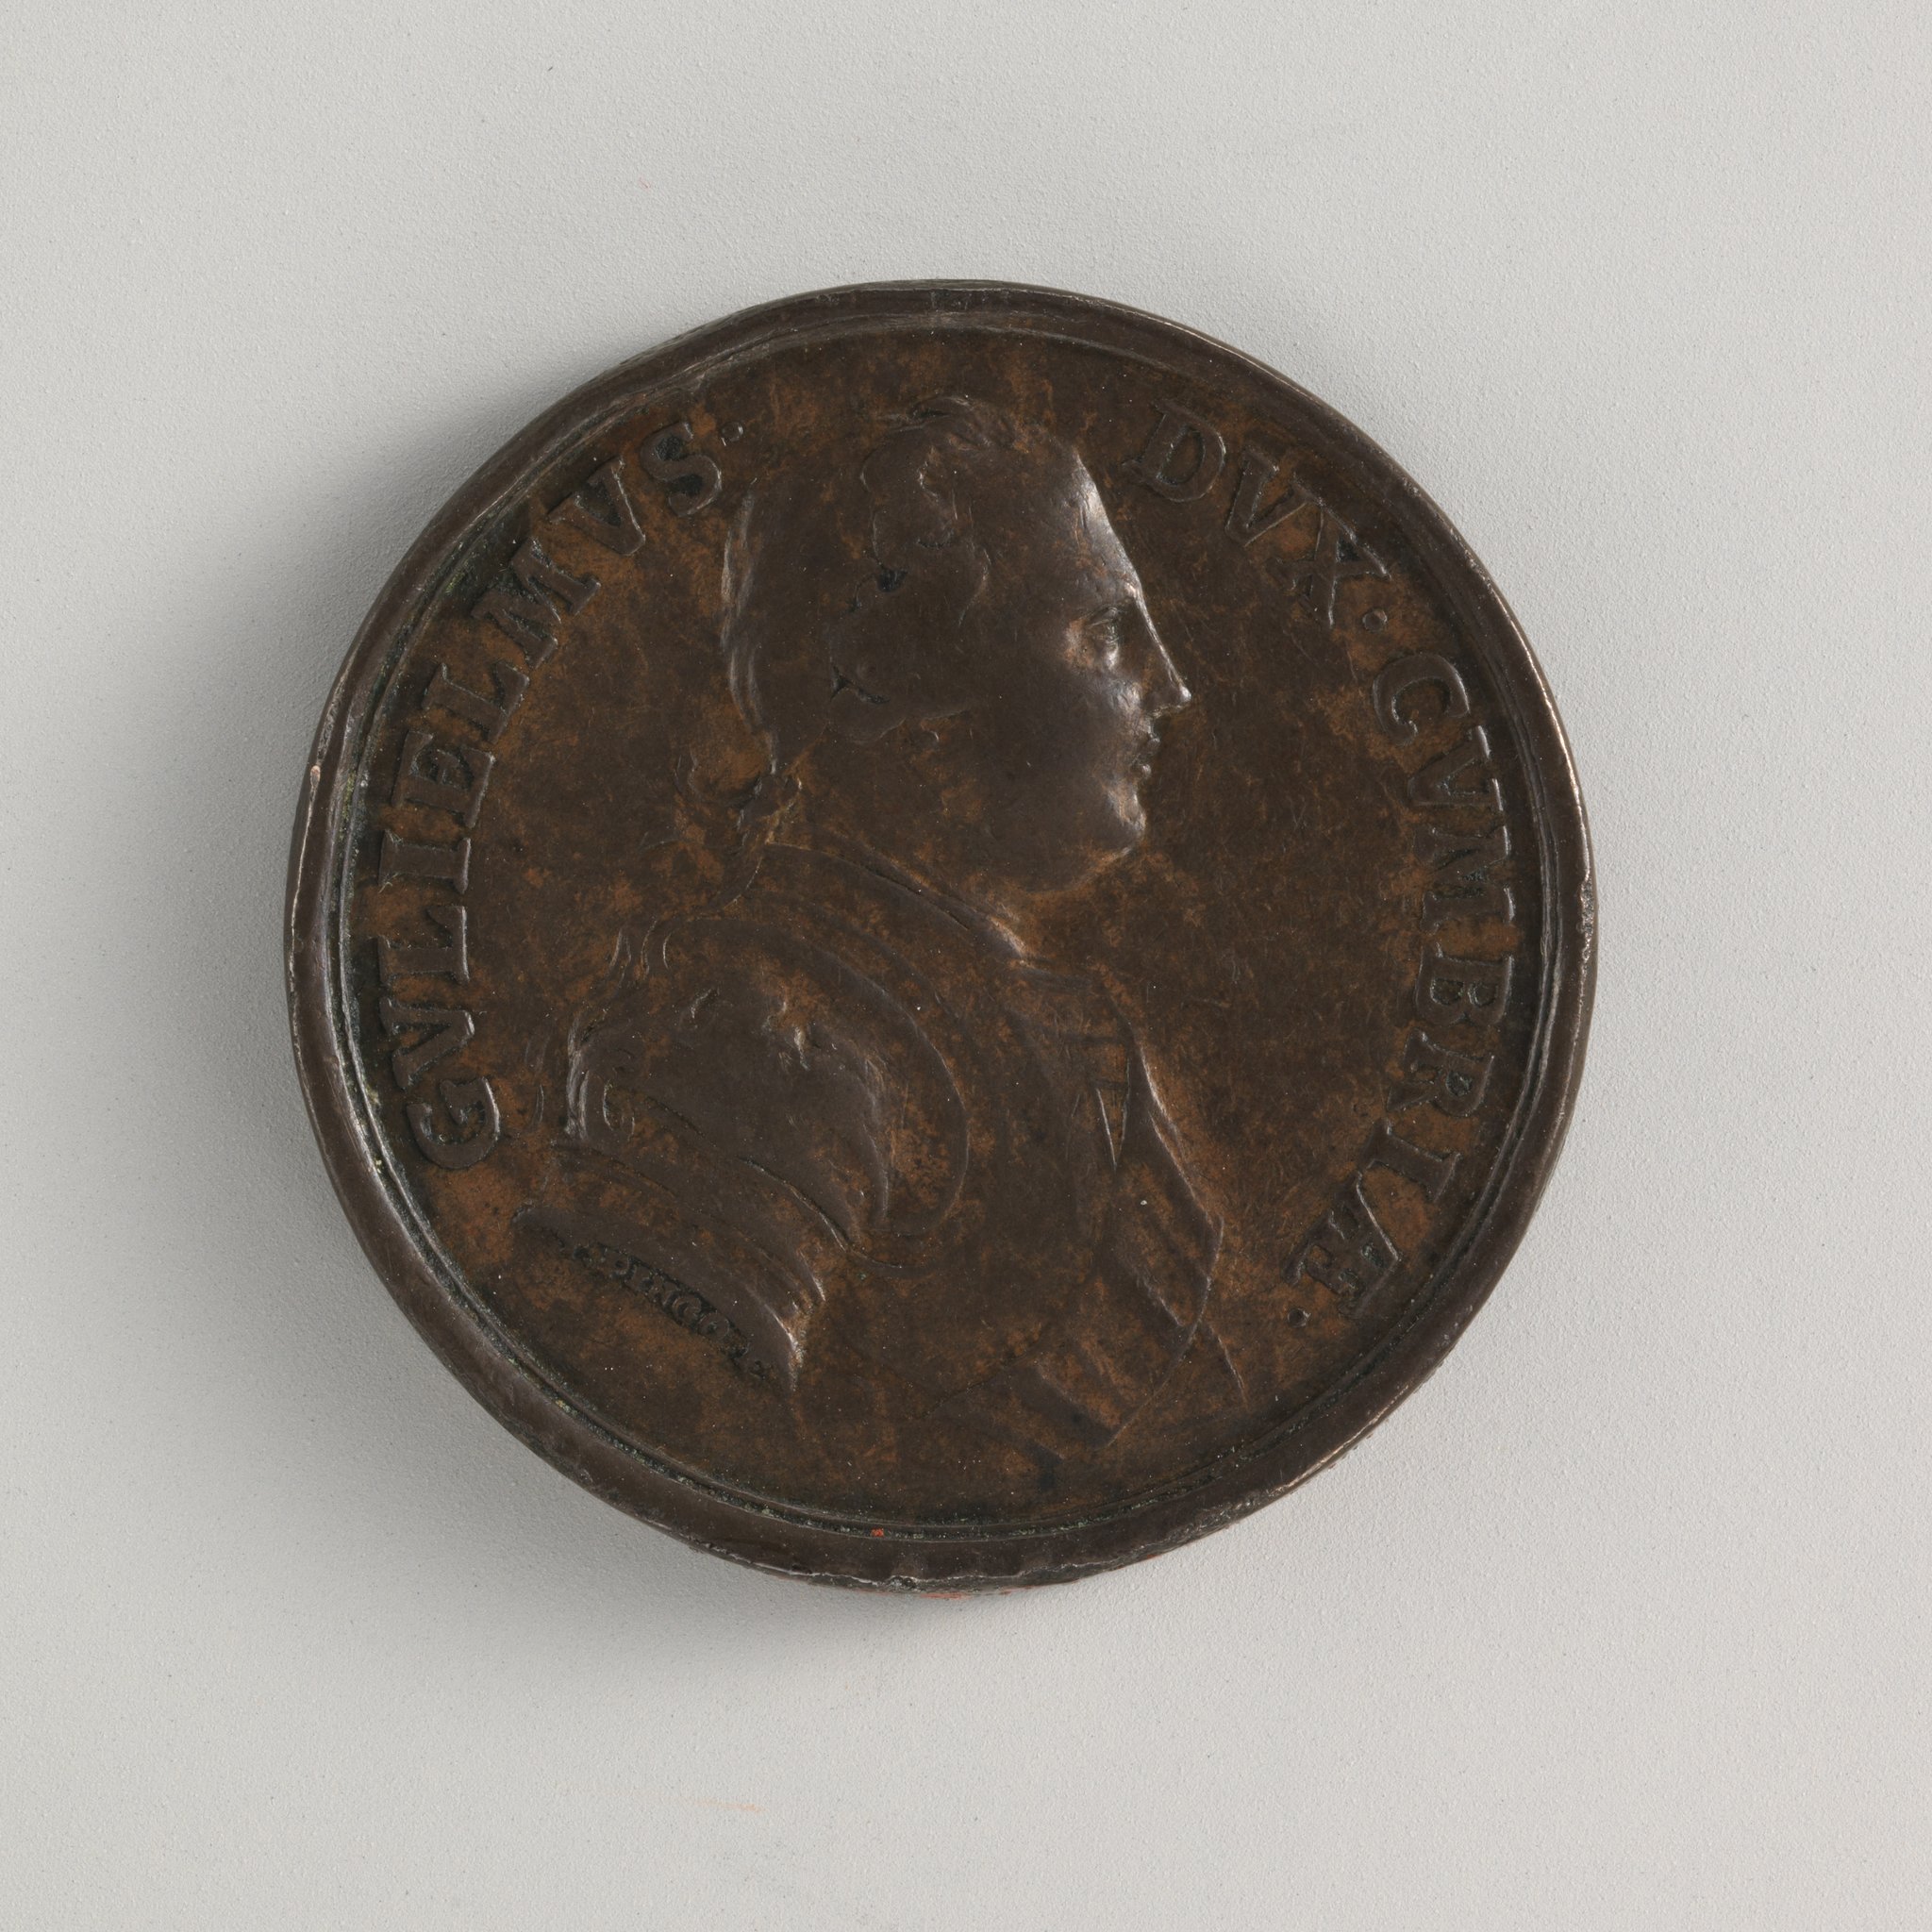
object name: medal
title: Theatre Royal Covent Garden Token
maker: thomas pingo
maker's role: artist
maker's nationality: italian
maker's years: 1692-1776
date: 1746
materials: bronze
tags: men,profiles